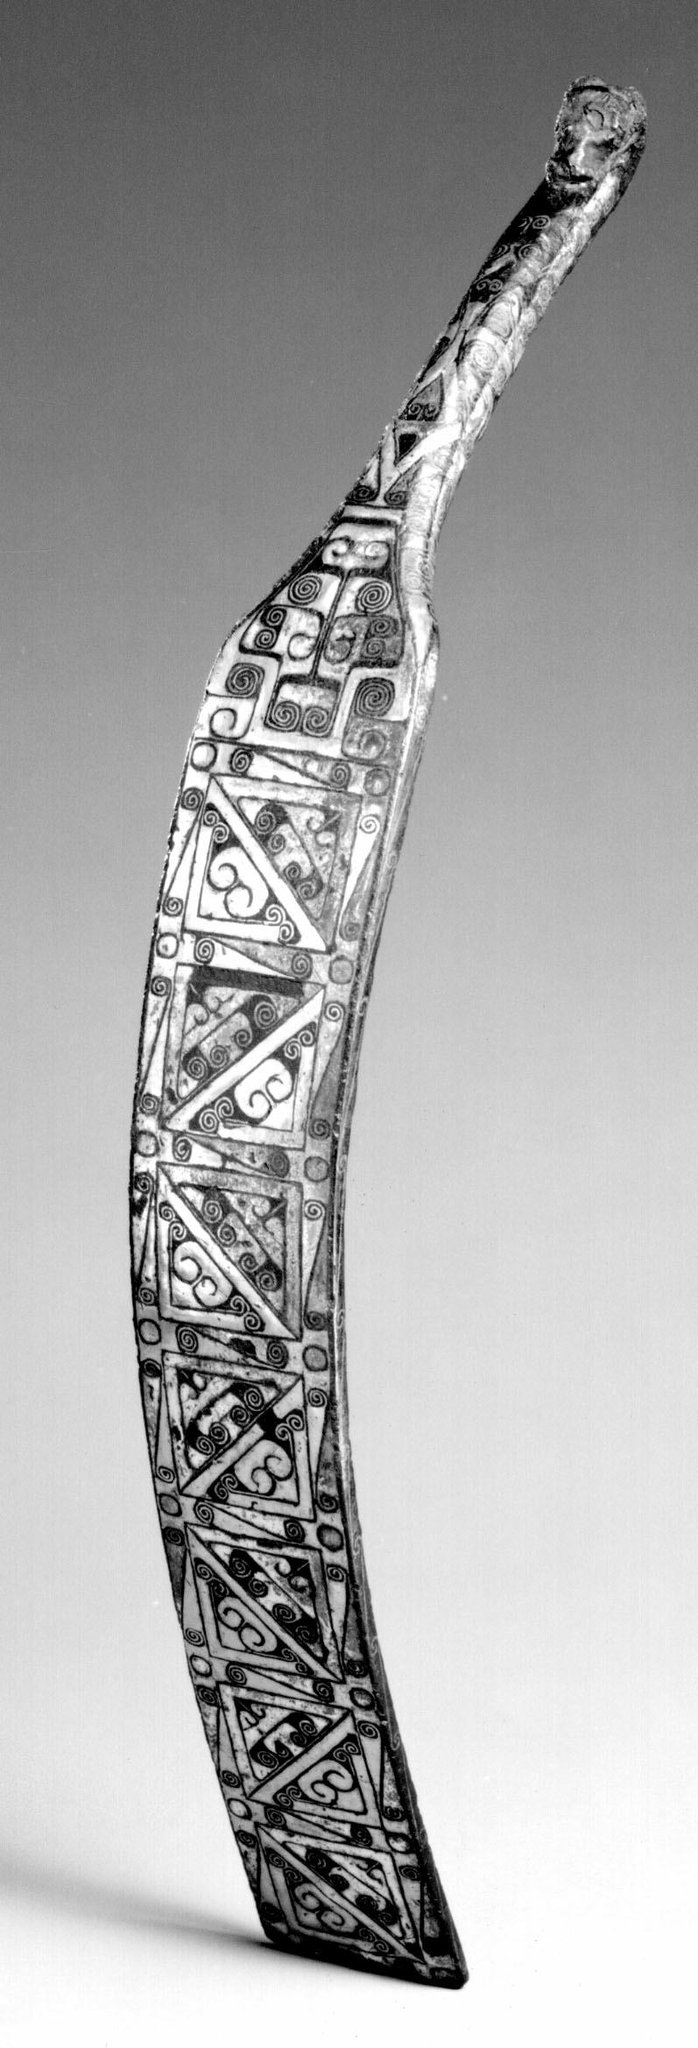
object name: belt hook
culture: chinese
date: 400-201 BCE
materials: gold, iron, silver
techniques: inlay